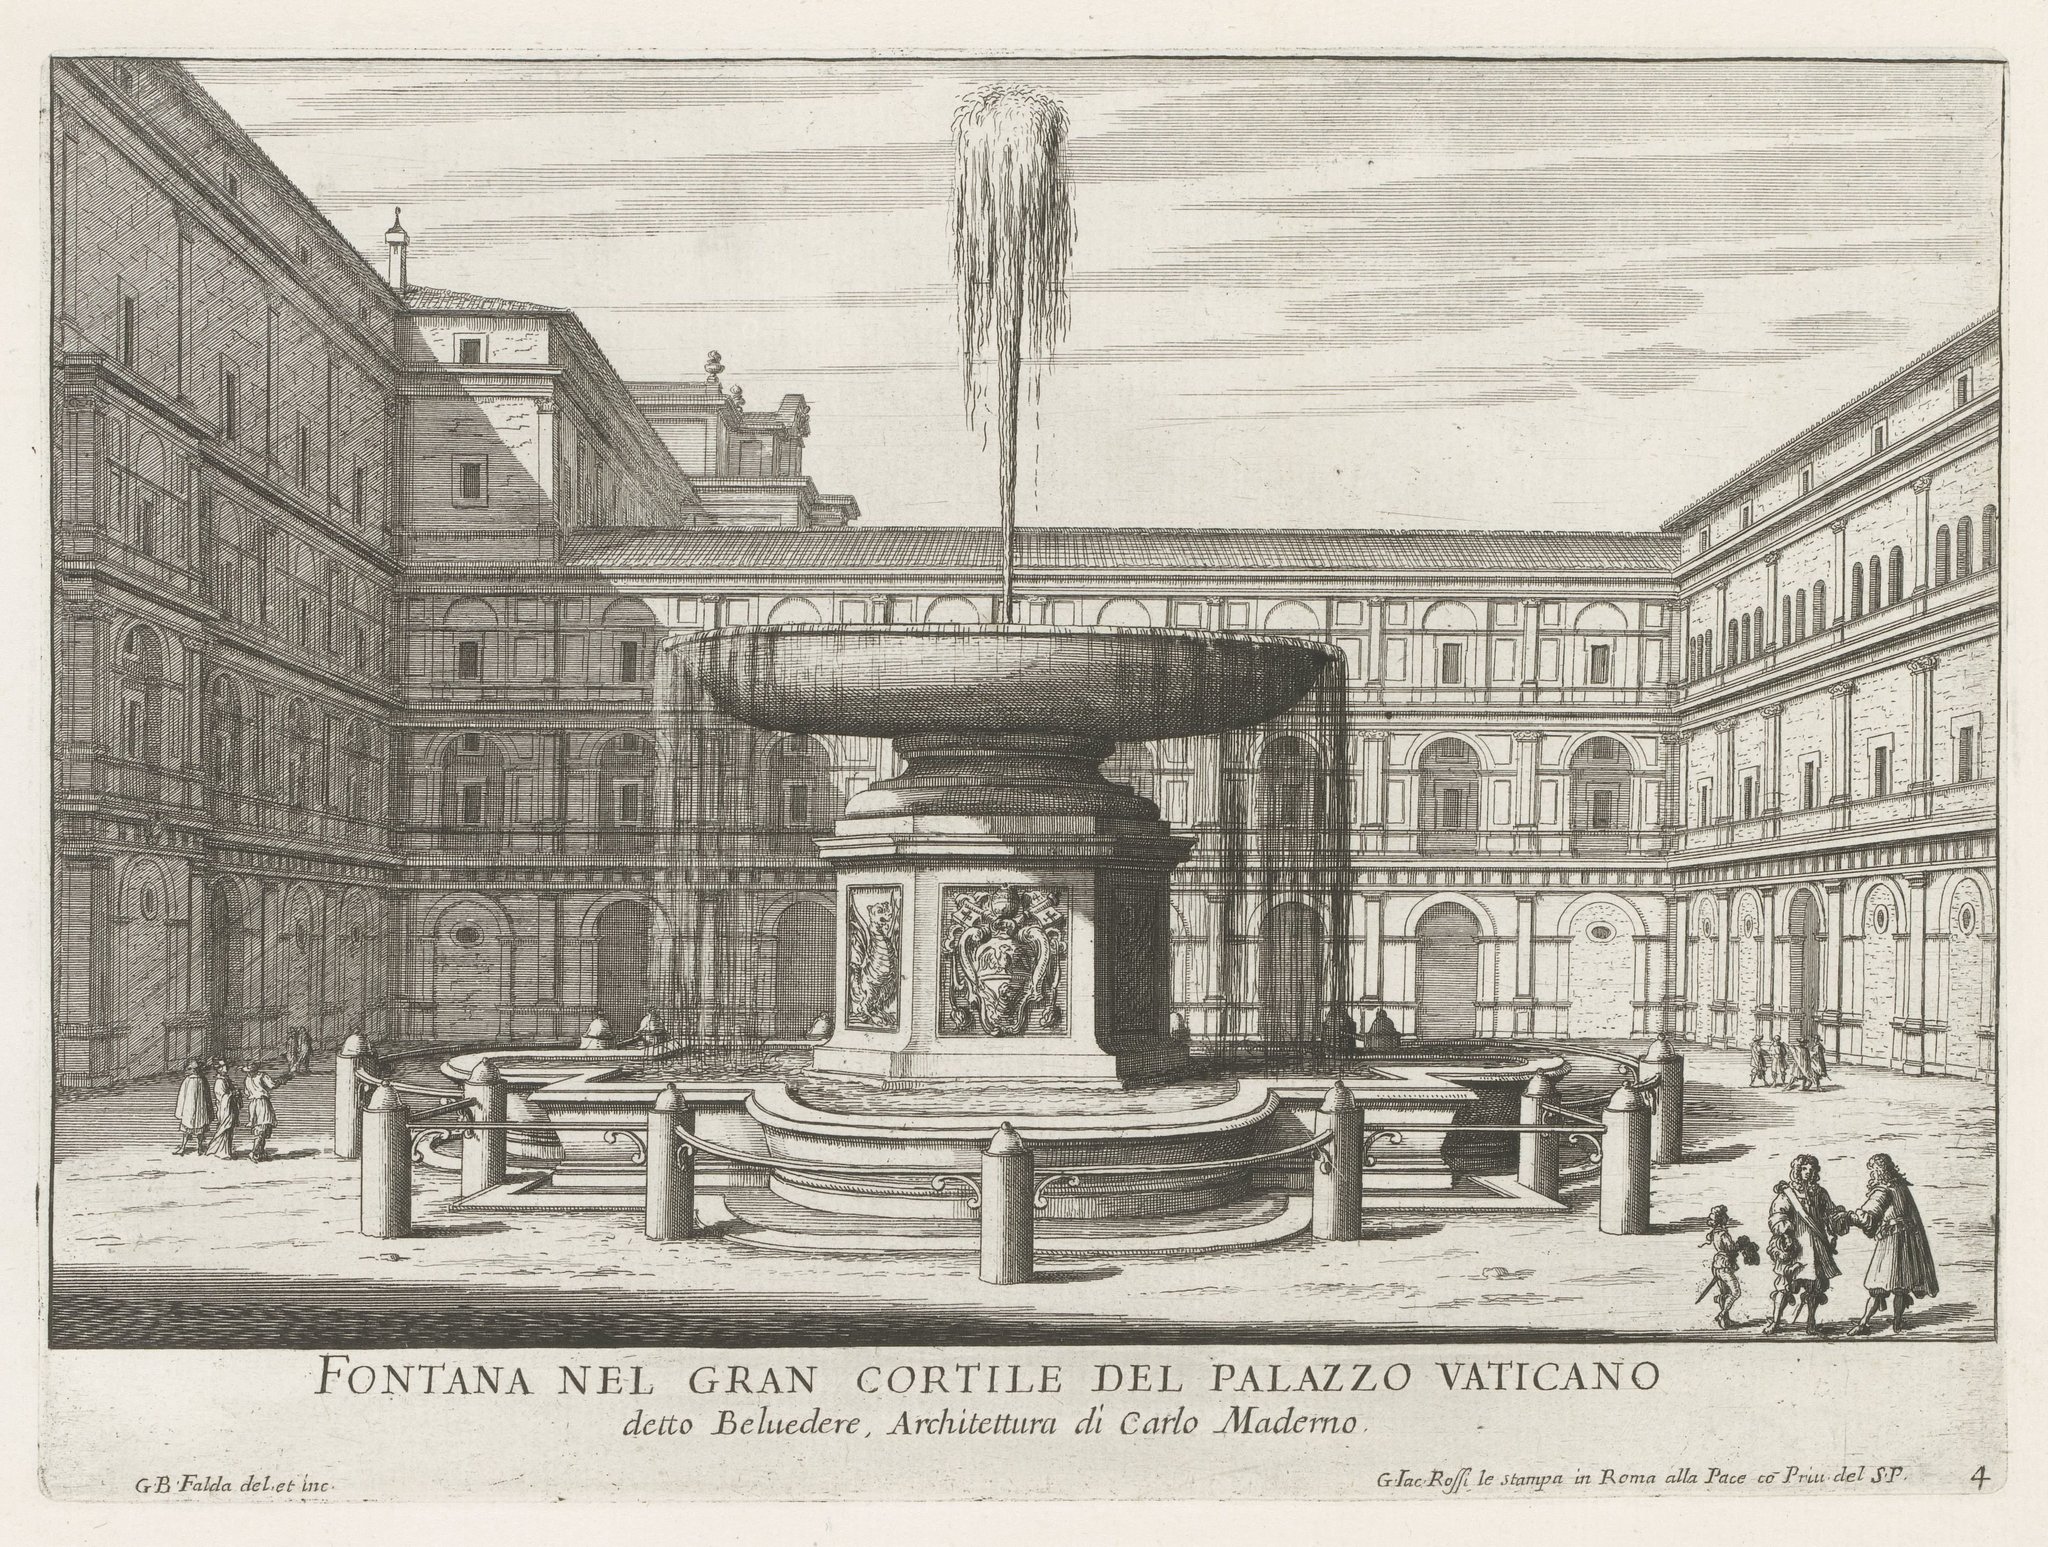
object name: album leaf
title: Fonteinen van Rome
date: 1653-1691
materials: paper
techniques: etching, intaglio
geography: italy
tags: ornamental fountain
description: Genummerd rechtsonder: 4. De prent maakt deel uit van een album.